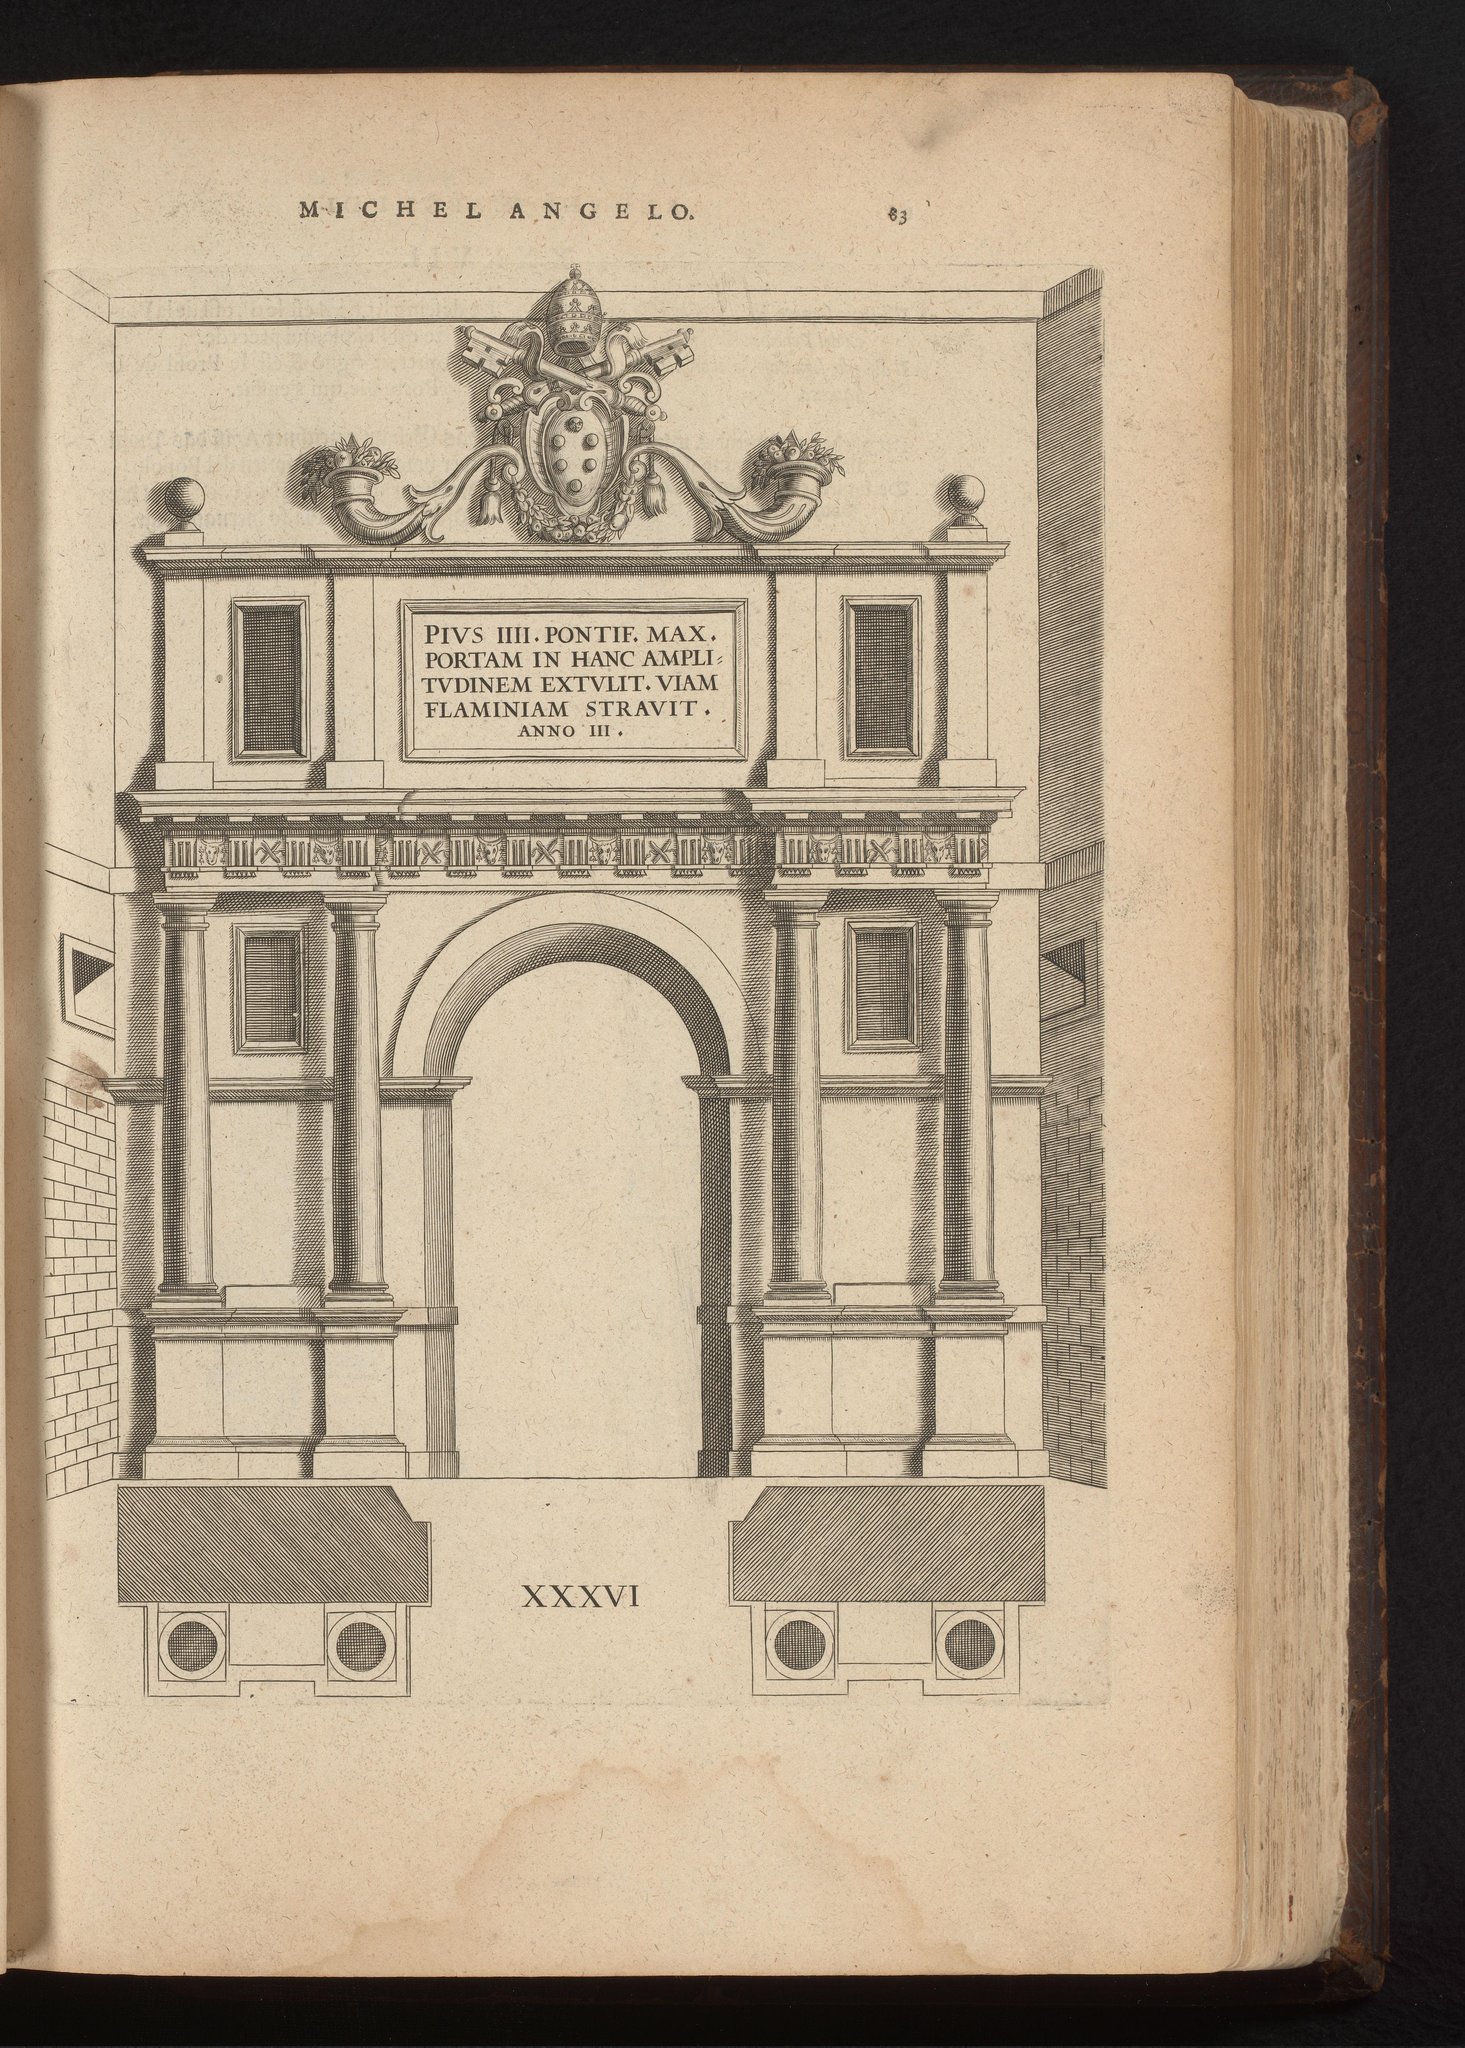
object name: book illustration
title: Porta del Popolo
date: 1640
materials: paper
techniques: engraving, letterpress printing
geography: amsterdam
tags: triumphal arch, architecture, armorial bearing, heraldry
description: Prent uit: Vignola, Giacomo Barozzi da. Regola delli cinque ordini d'architettura (...). Amsterdam: Johannes Willemszoon en Cornelis Blaeu, 1640, p. 83.